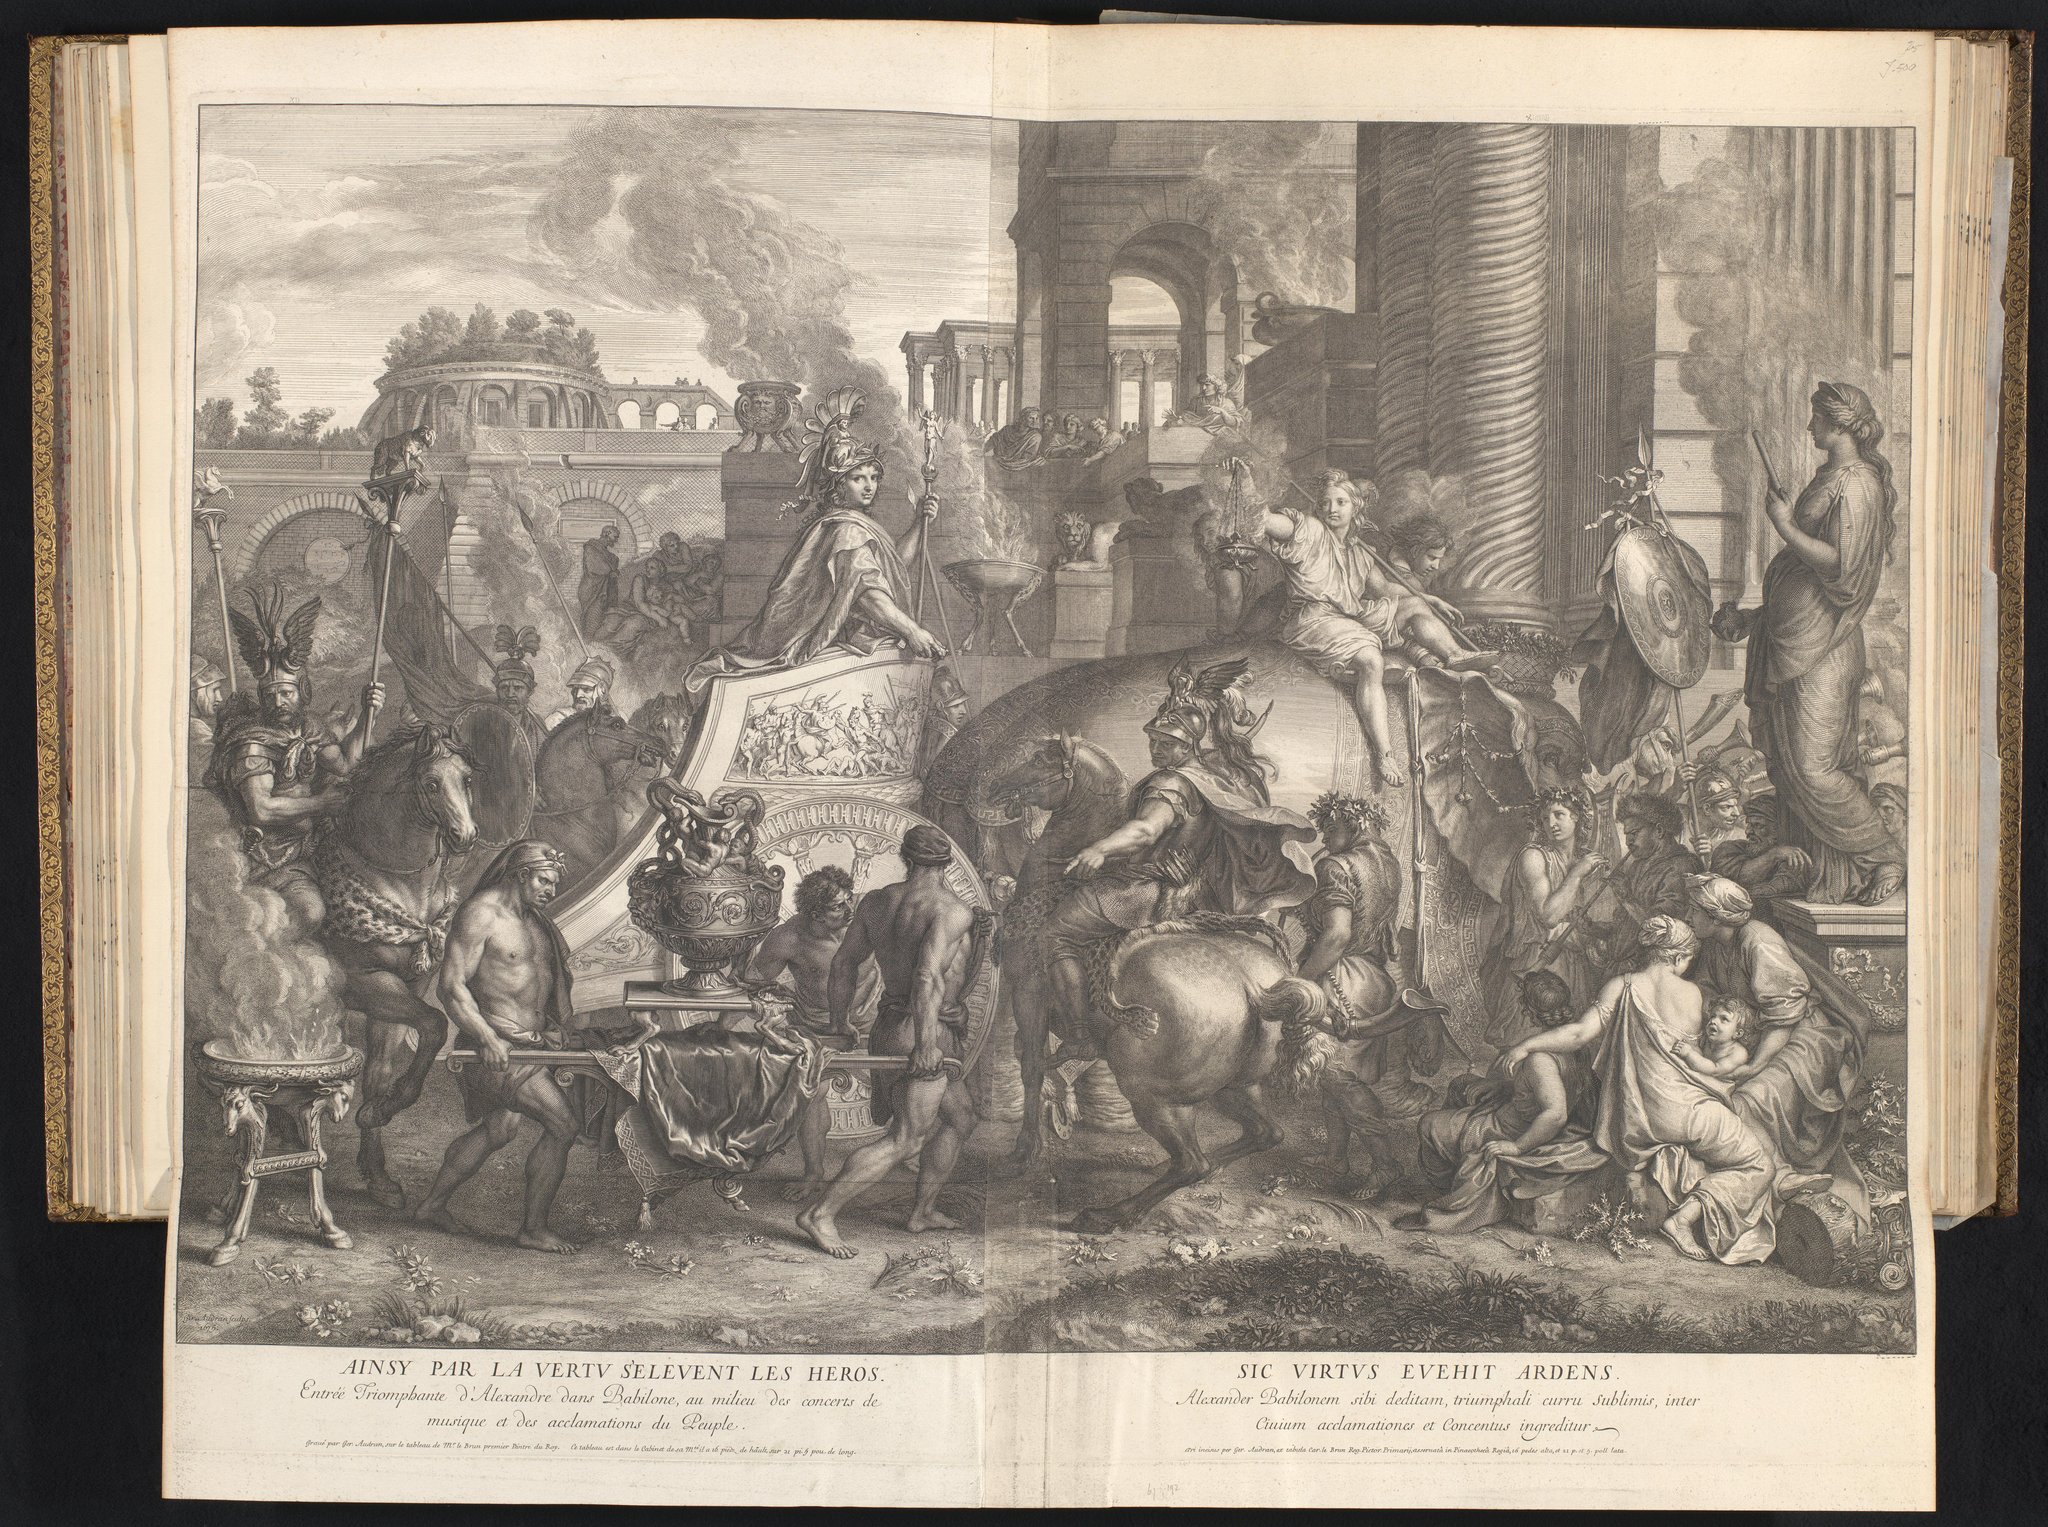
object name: print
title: Ainsy par la vertu s'elevent les heros / Sic virtus evehit ardens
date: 1675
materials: paper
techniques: engraving, etching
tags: alexander's triumphal entry into babylon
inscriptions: date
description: Deze prent maakt deel uit van een album.